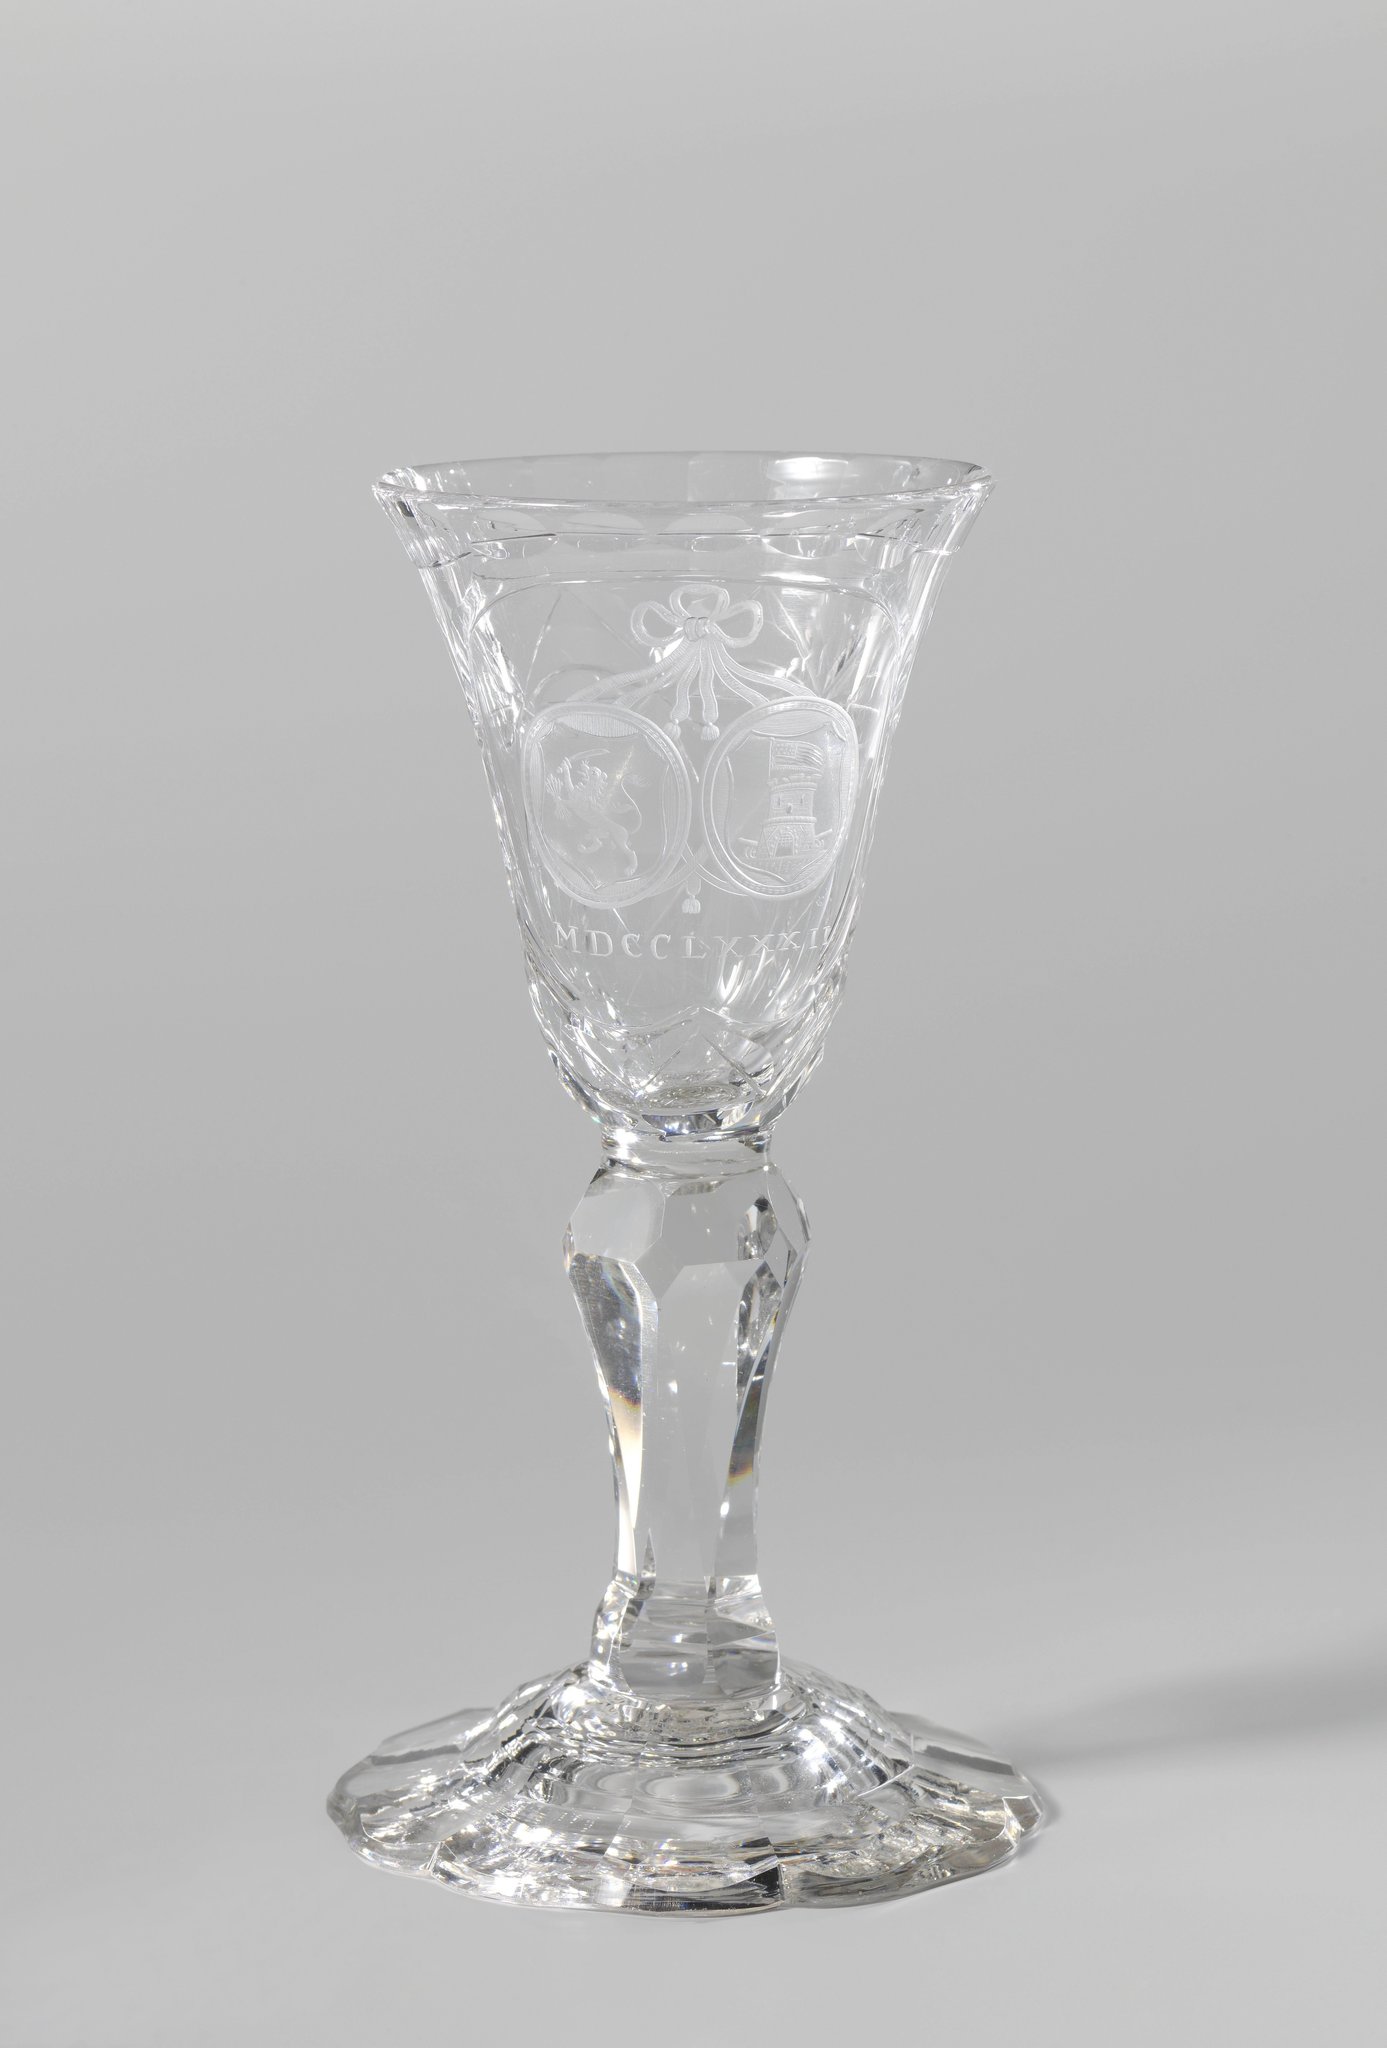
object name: goblet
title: Wine glass with the coat of arms of the Dutch States-General and the flag of the United States of America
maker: Anonymous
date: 1782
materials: glass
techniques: glassblowing, grinding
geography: northern netherlands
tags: symbols of particular nations, states, districts, etc., netherlands, united states of america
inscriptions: date: ‘MDCCLXXXII’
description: The coats of arms on this glass depict the lion of the Seven United Provinces and a castle with the (slightly erroneously drawn) flag of the United States of America. In 1782 the Dutch officially recognized the United States, and John Adams was appointed as envoy. Later that year the first Trade and Friendship Treaty was signed between the two nations.